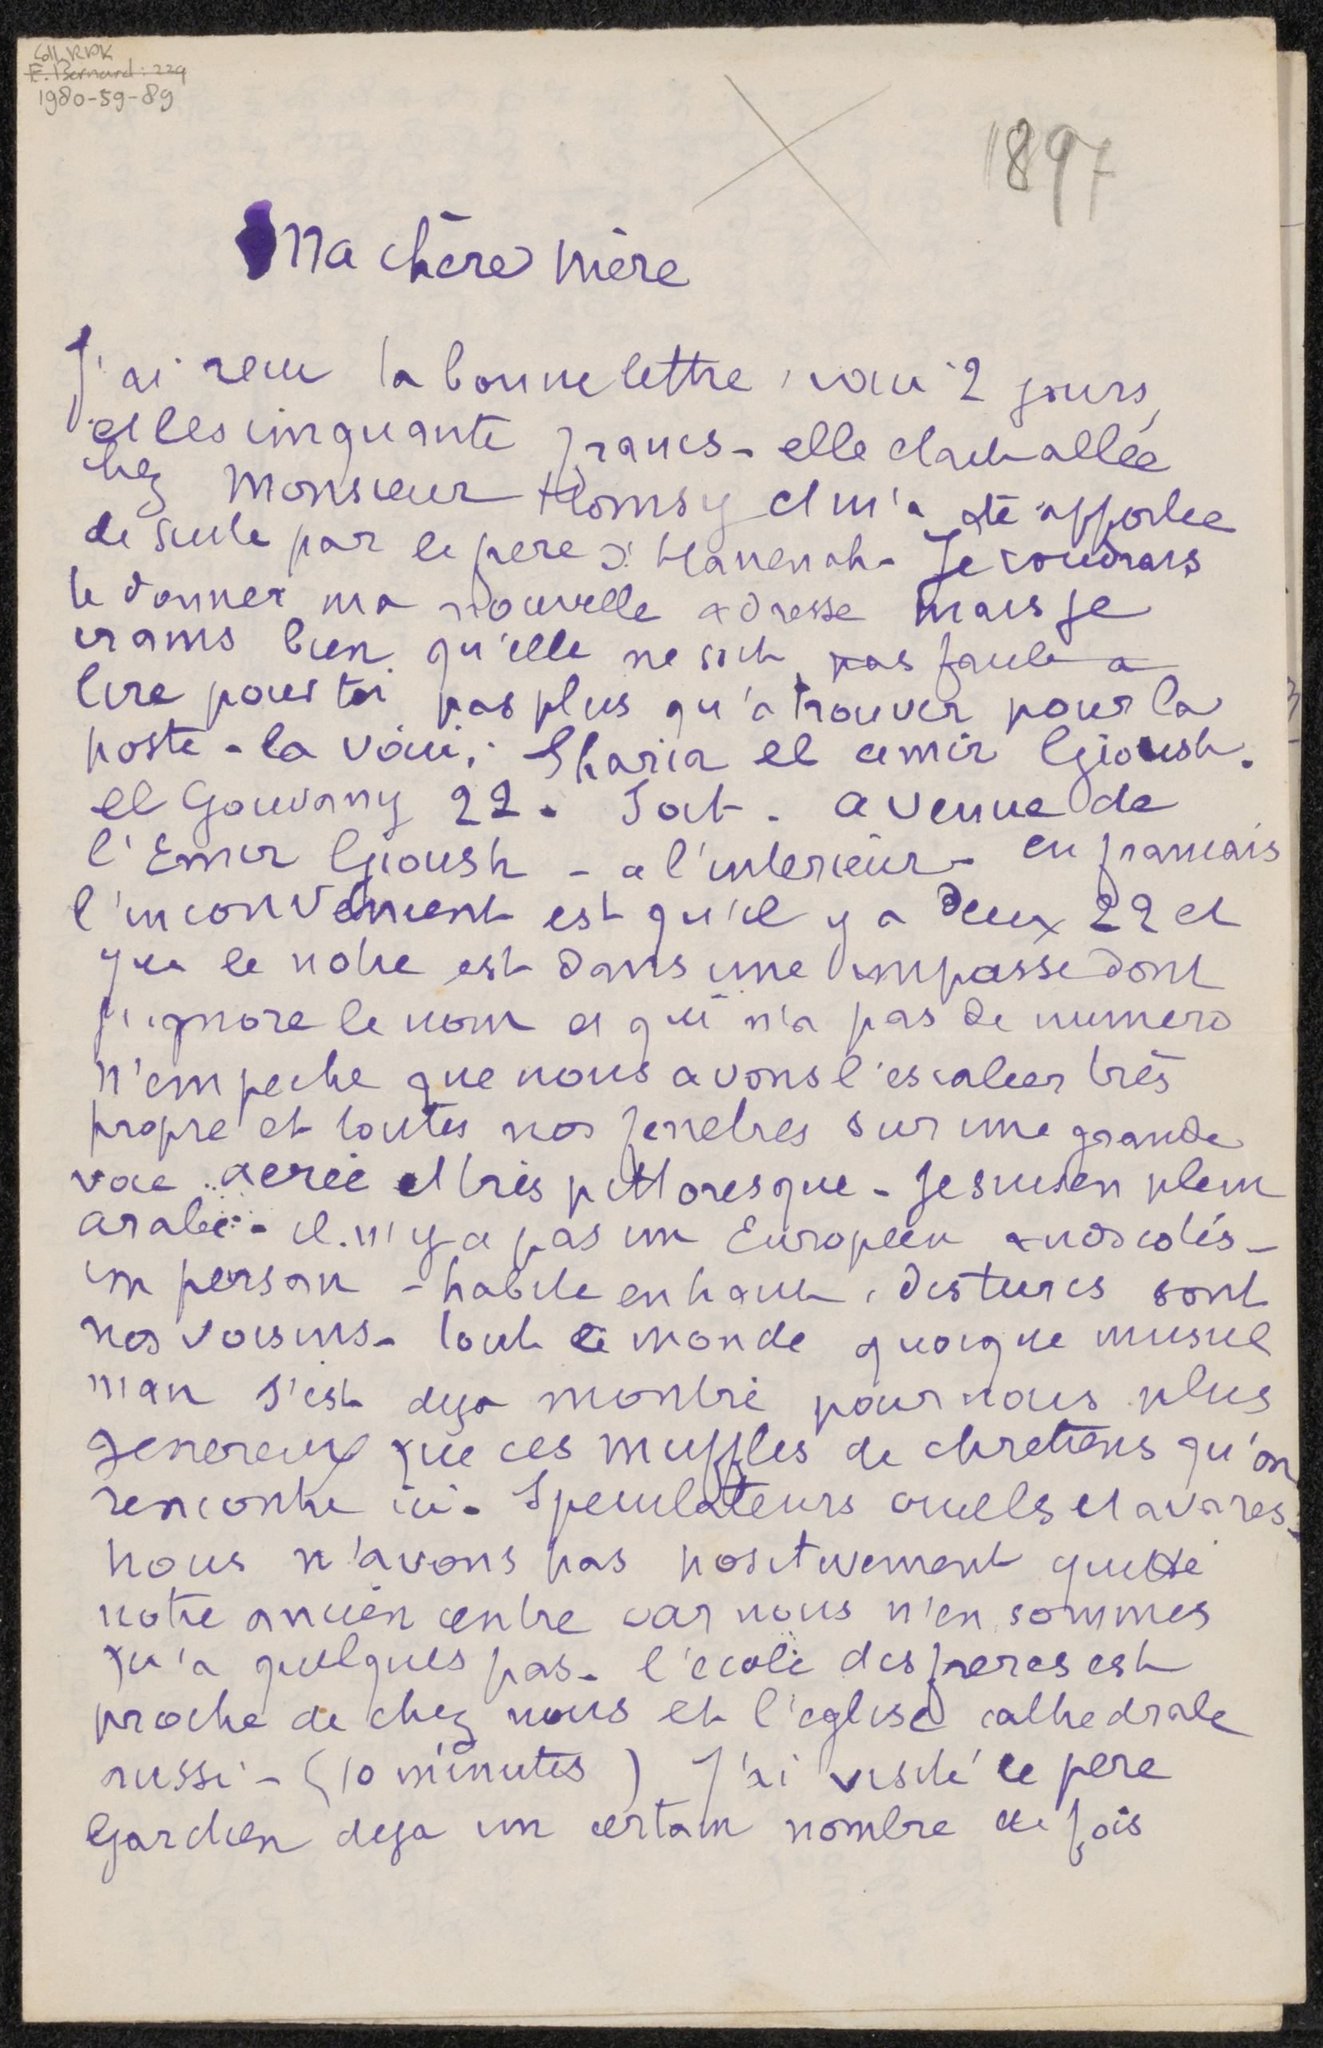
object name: letter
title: Brief aan Héloïse Bernard-Bodin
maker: émile bernard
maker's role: print maker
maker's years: 1868-1941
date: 1878-1941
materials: ink, paper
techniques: pen, writing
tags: héloïse bernard-bodin